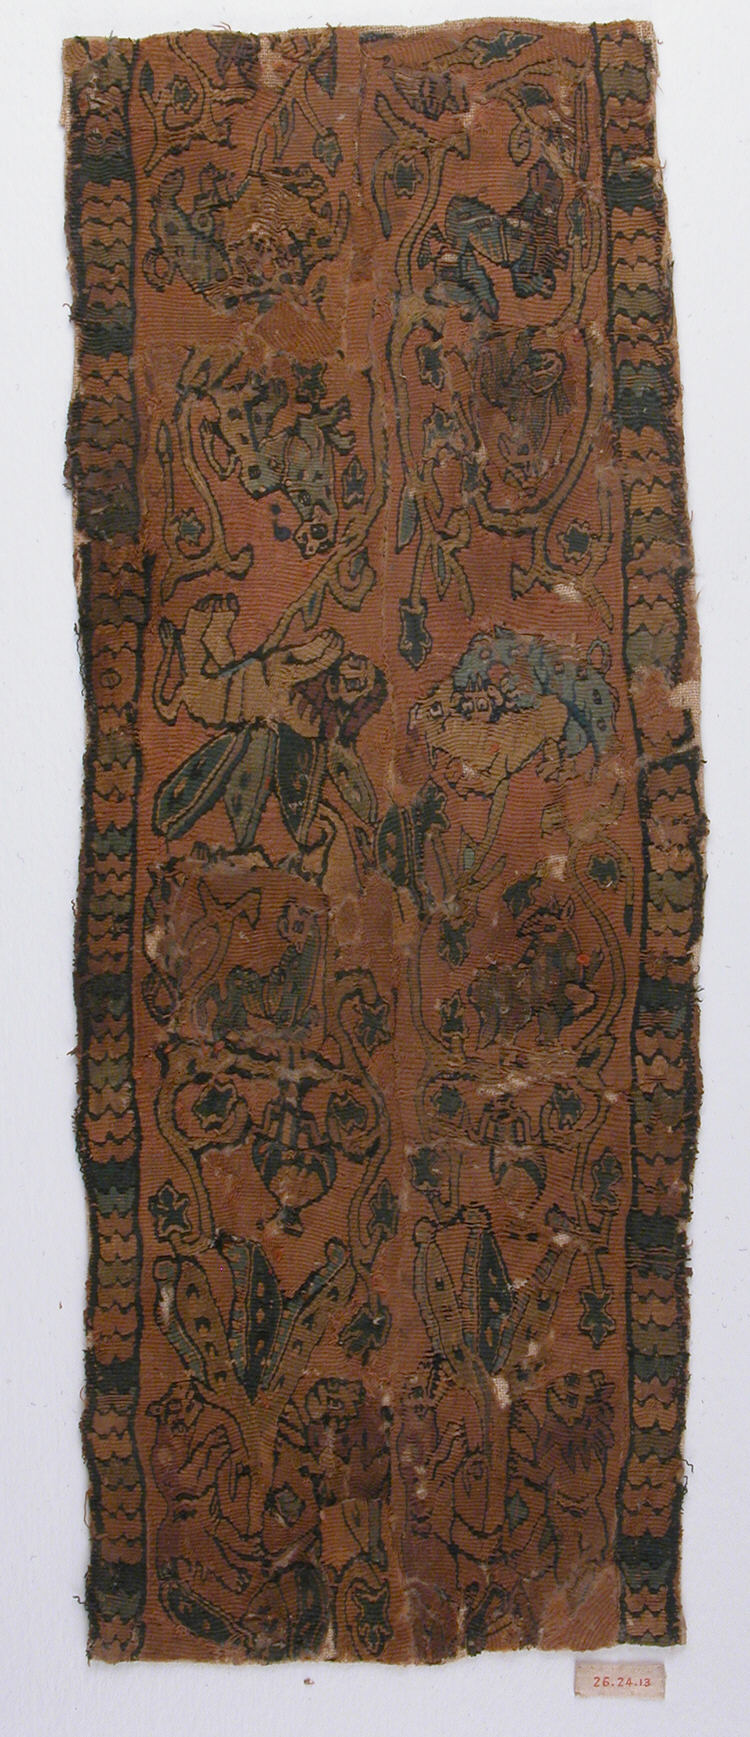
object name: band fragment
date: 501-600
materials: linen, wool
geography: egypt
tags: mythical creatures